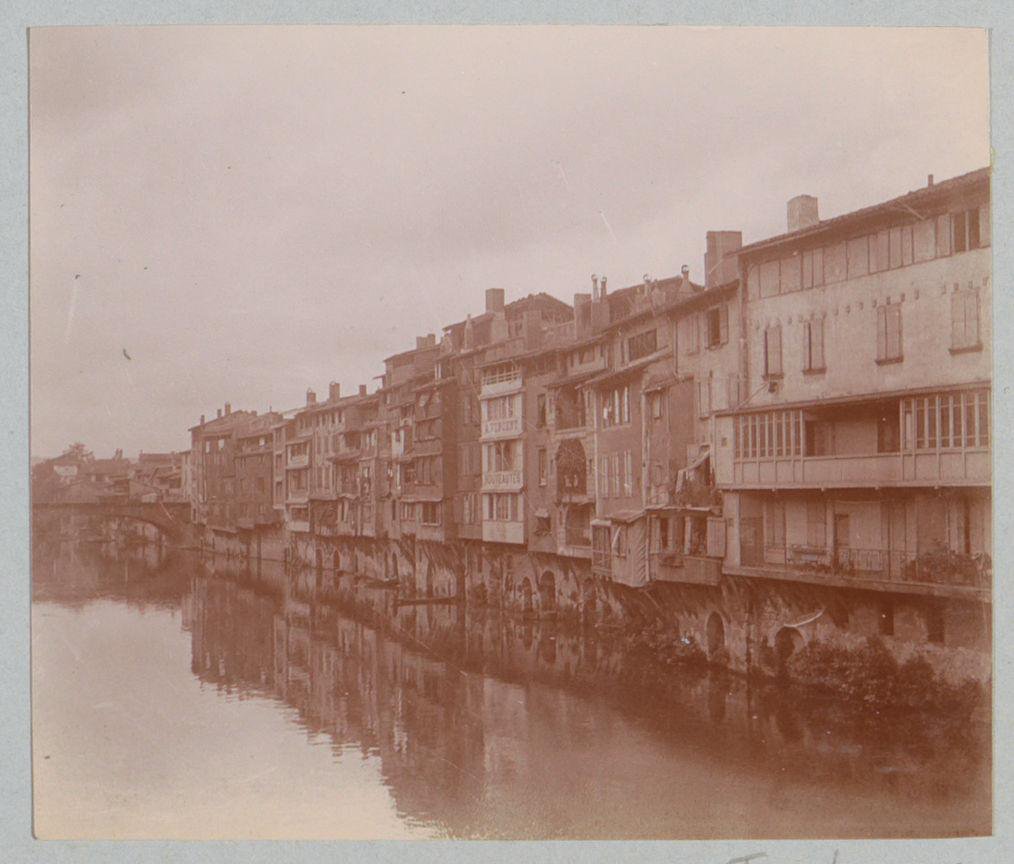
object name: photograph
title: Gezicht op een rij huizen aan een water, vermoedelijk in Frankrijk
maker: Anonymous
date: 1905-1910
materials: paper, photographic support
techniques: gelatin silver print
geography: france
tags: river, façade (of house or building), france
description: Onderdeel van Fotoalbum van een Franse amateurfotograaf met bezienswaardigheden in Frankrijk, Zwitserland en Italië.